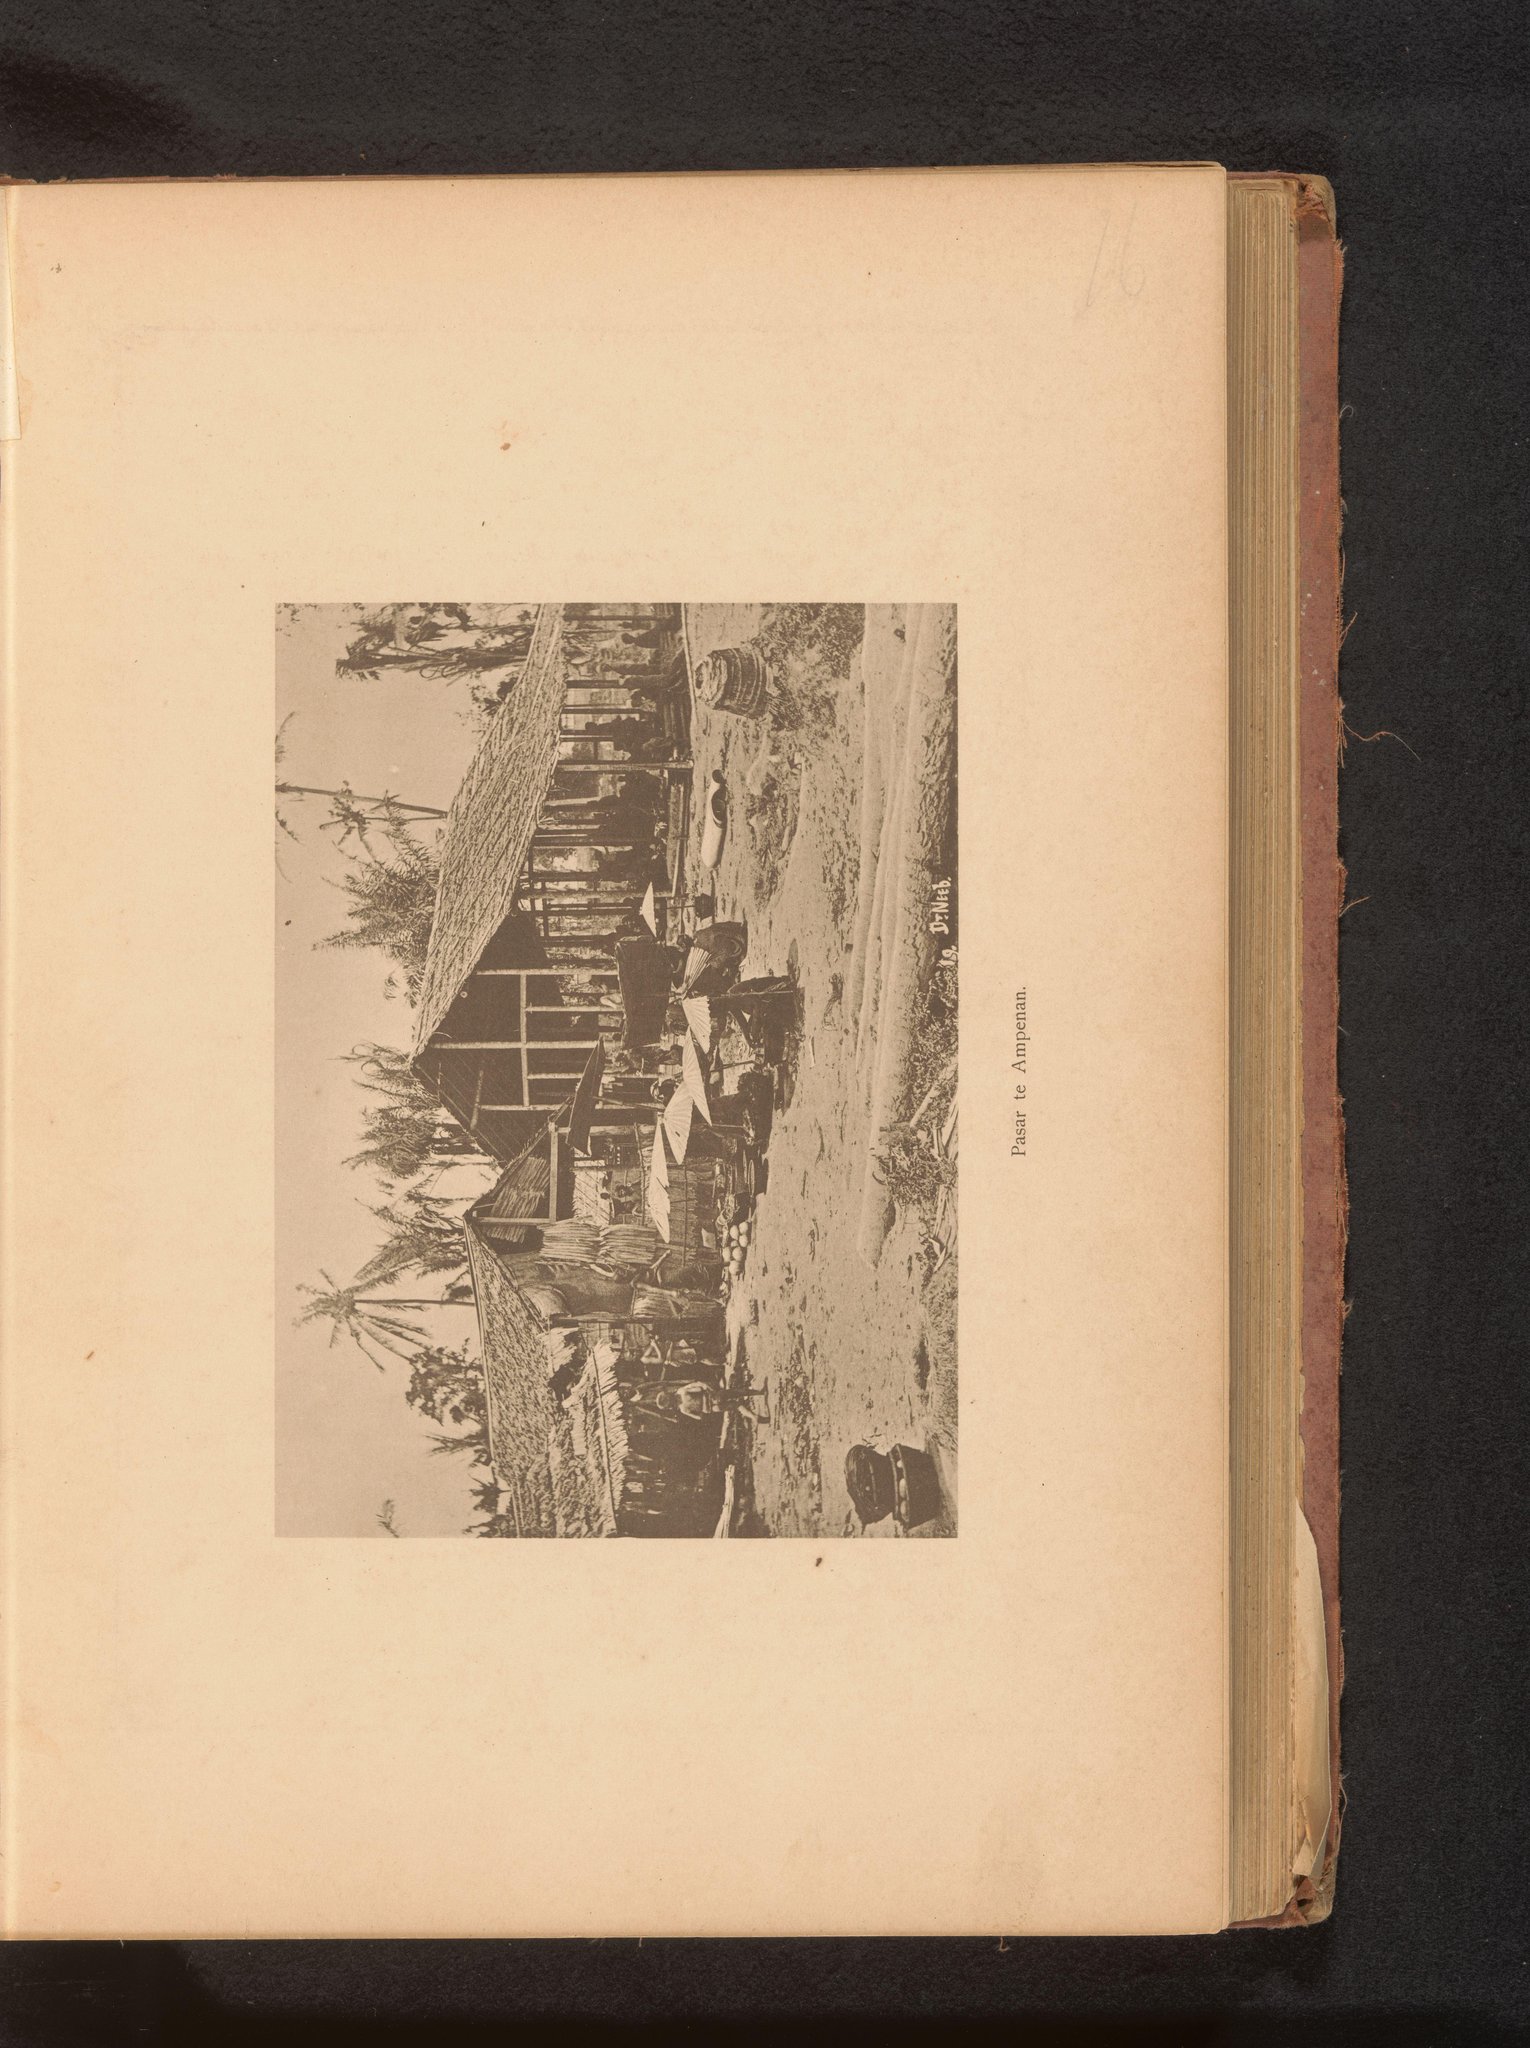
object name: photomechanical print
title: Pasar te Ampenan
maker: christiaan johan neeb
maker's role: arts, fotograaf, officier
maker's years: 1860-1925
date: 1892-1897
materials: paper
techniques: photograph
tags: market, parasol, sunshade